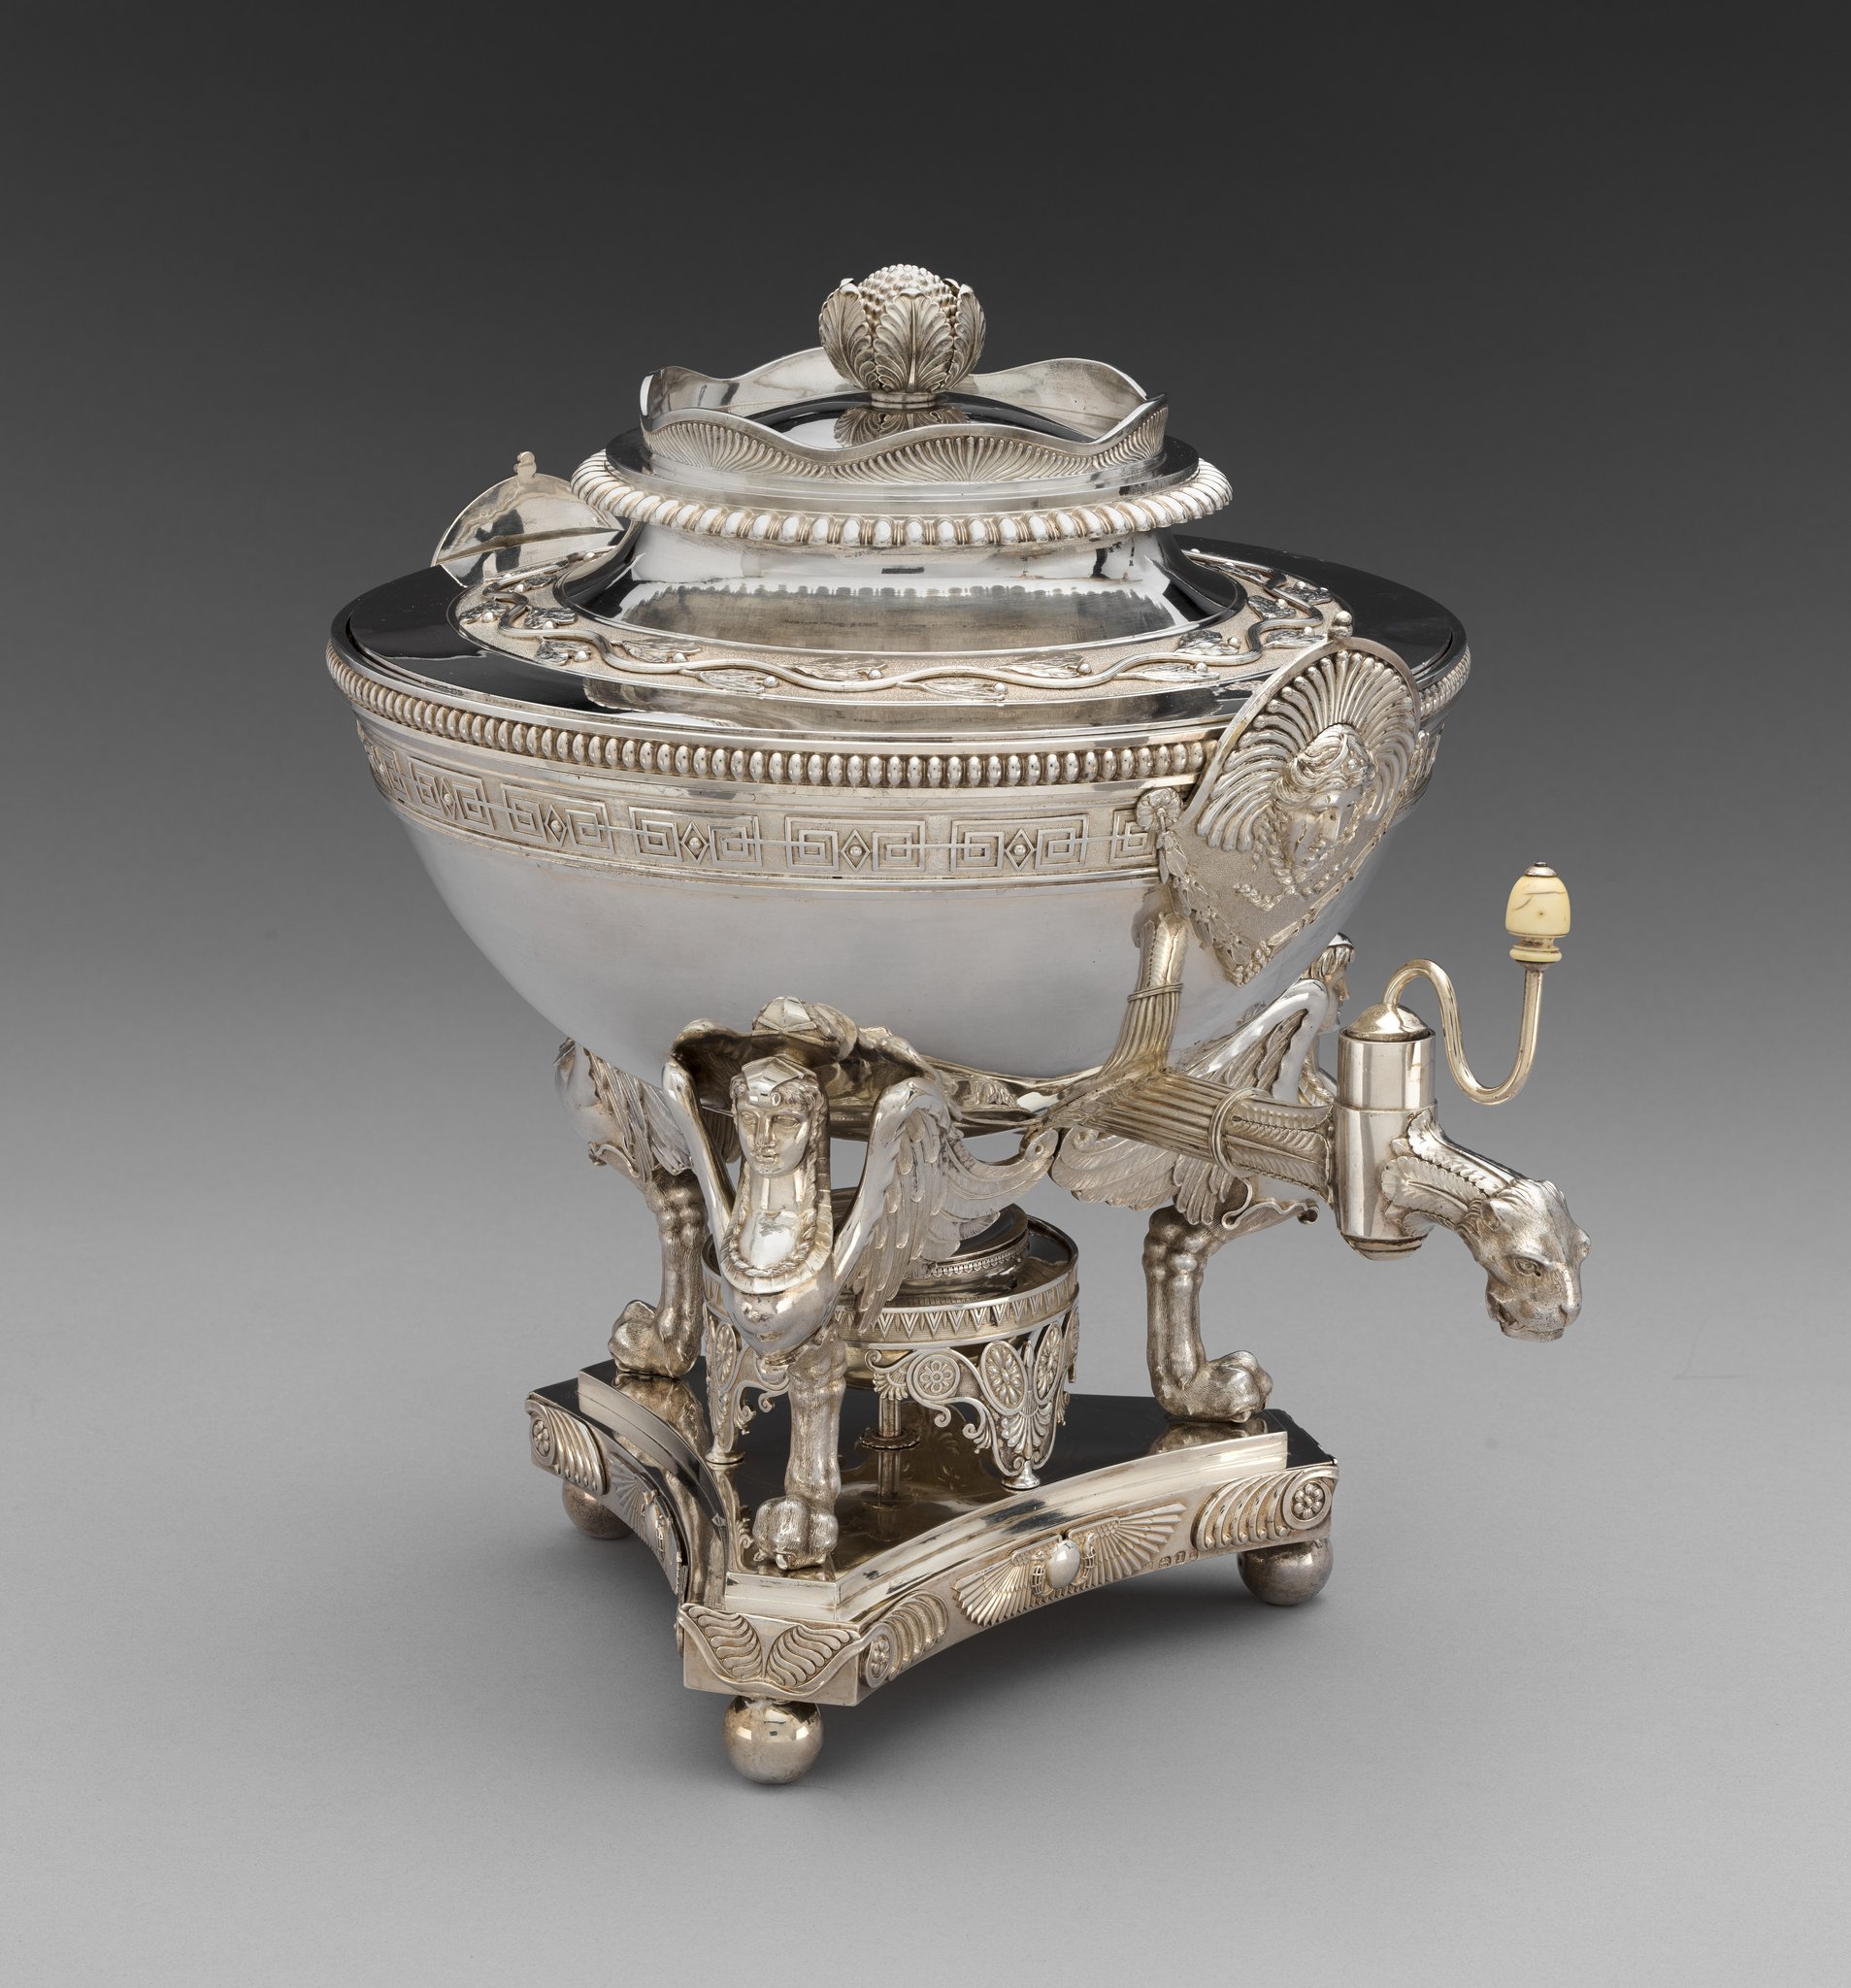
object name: hot water urn part of a service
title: Hot Water Urn (part of a service)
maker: digby scott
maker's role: maker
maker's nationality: british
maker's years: 1780-1880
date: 1804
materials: ivory, silver